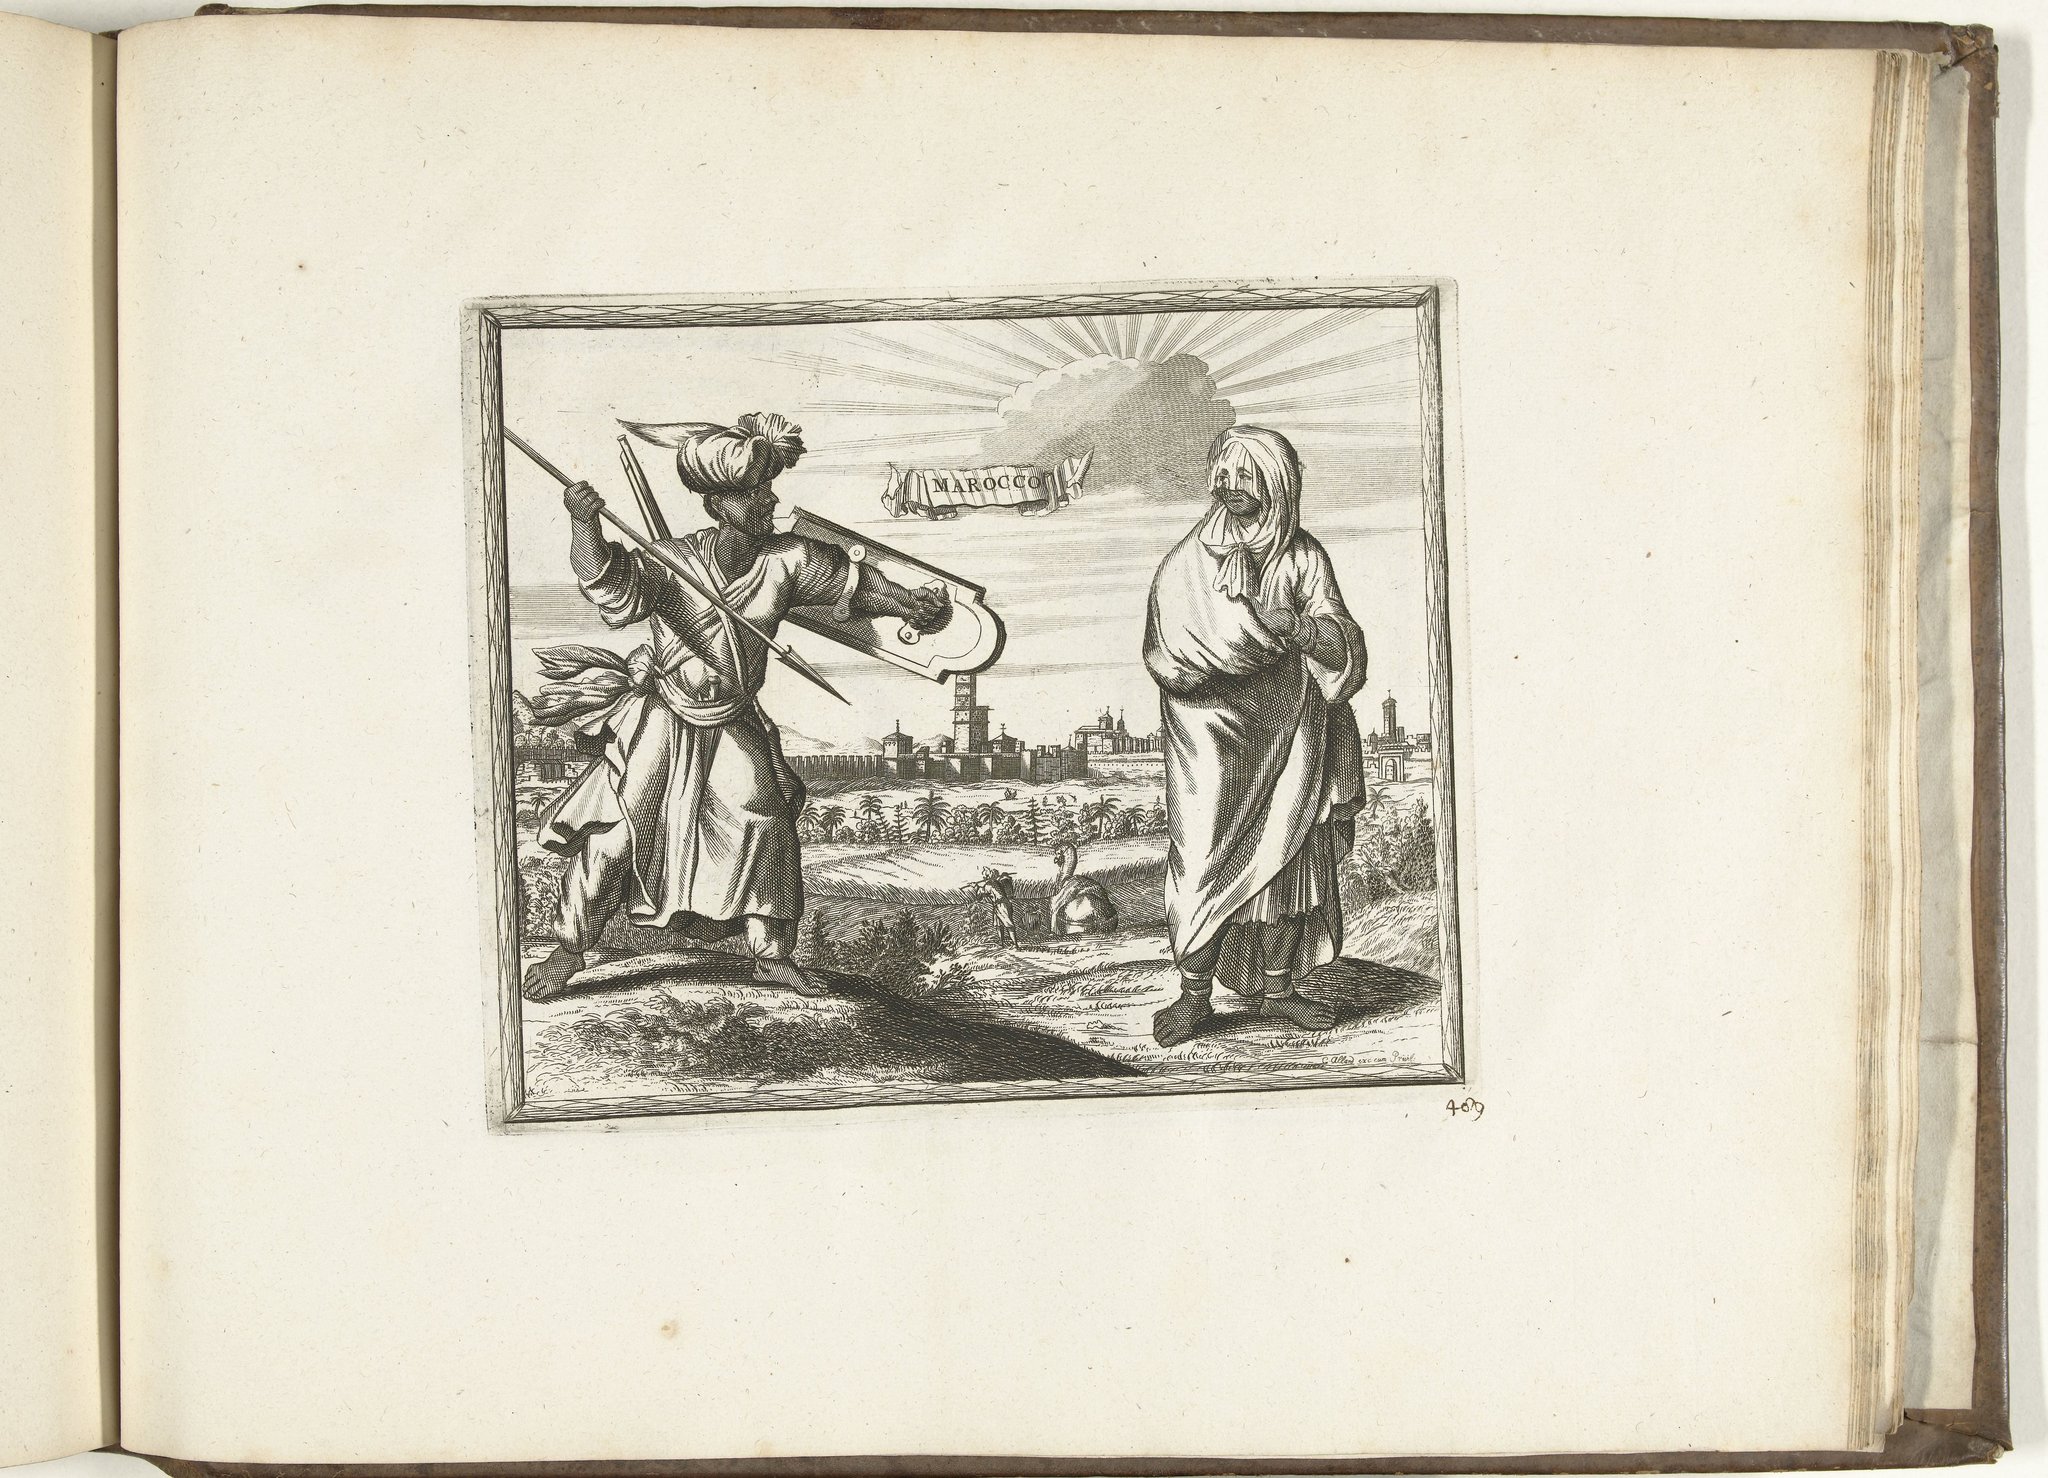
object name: costume print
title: Marocco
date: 1726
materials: paper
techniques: engraving, etching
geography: leiden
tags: africans, folk costume, regional costume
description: Man en vrouw van Marokko, gekleed in lokaal kostuum, op de achtergrond een stad. Plaat nr. 489 in deel XX van het prentwerk: Les Forces de l'Europe, Asie, Afrique et Amerique ... Comme aussi les Cartes des Côtes de France et d'Espagne uit 1726, dit tweede deel met 271 met de hand genummerde platen van vermaarde sterke steden en vestingen in het kader van de Spaanse Successieoorlog 1701-1713. Voor het merendeel zijn deze platen gekopieerd naar de anonieme Franse platen van vermaarde sterke steden en vestingen: in Les forces de l'Europe en in: Le theatre de la guerre, dans les Pays-Bas, beide oorspronkelijk uitgegeven door Nicolas de Fer te Parijs (1693-1697) in het kader van de Negenjarige Oorlog.